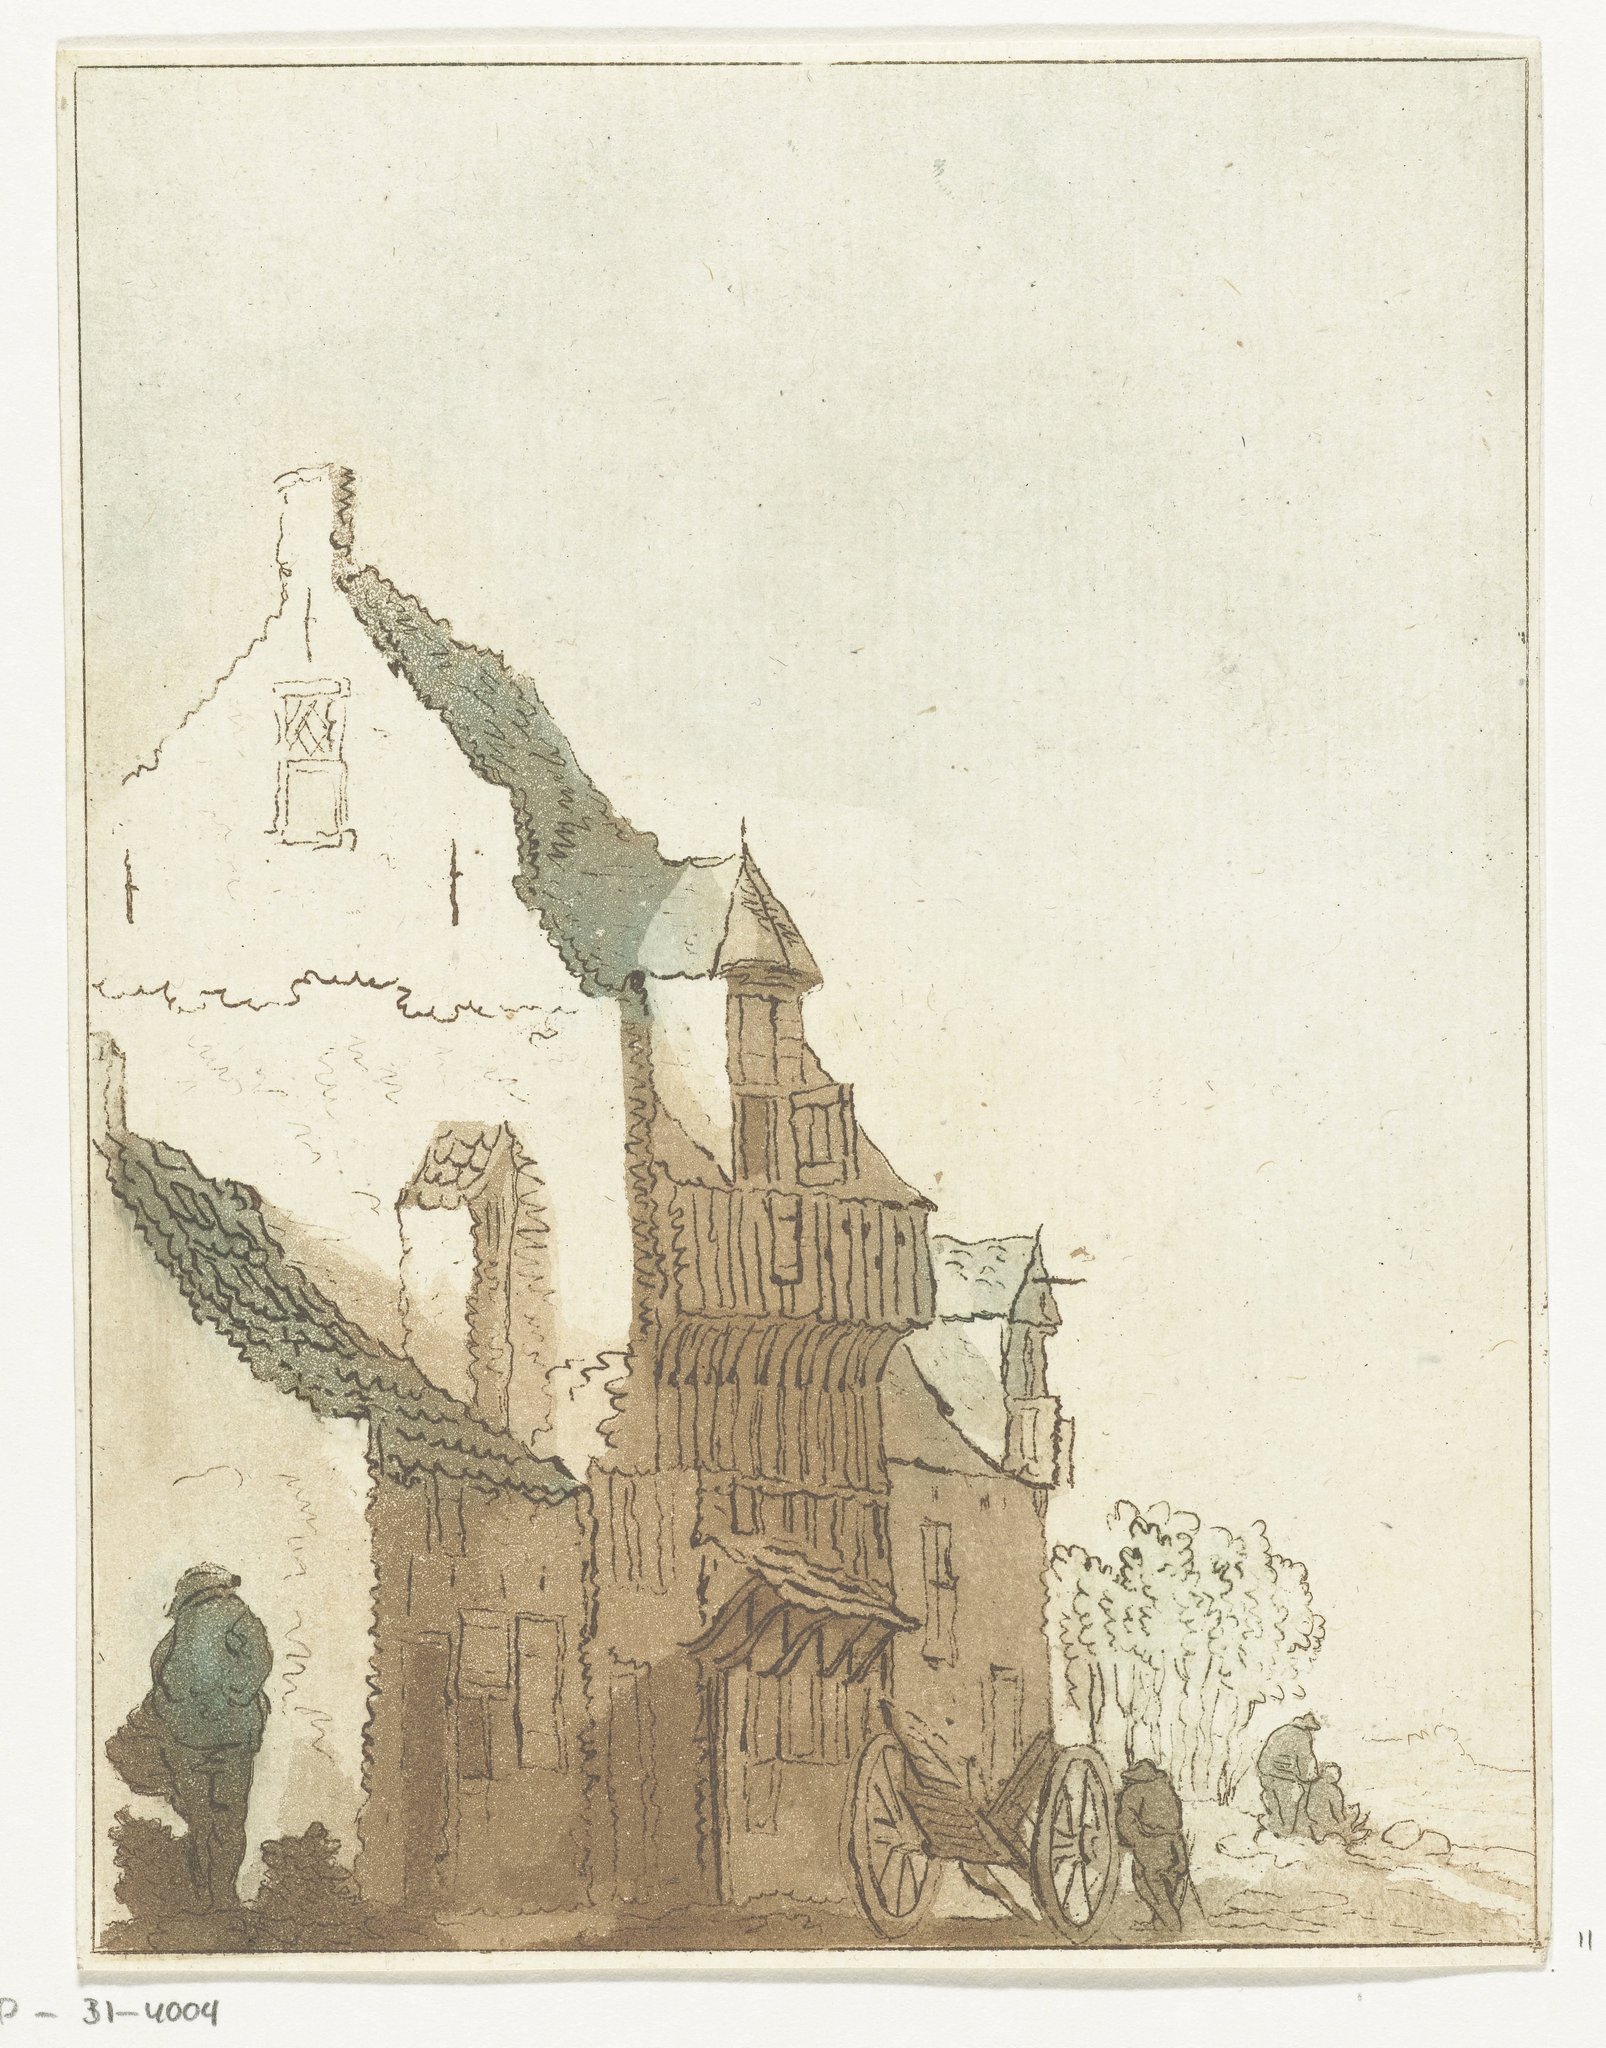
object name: print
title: Huis met kruiwagen voor de deur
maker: anthonie van den bos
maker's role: draughtsman, print maker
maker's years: 1763-1838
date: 1778-1838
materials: paper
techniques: aquatint, etching, lithography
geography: netherlands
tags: the usual house or row of houses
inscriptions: collector's mark: Lugt 2228